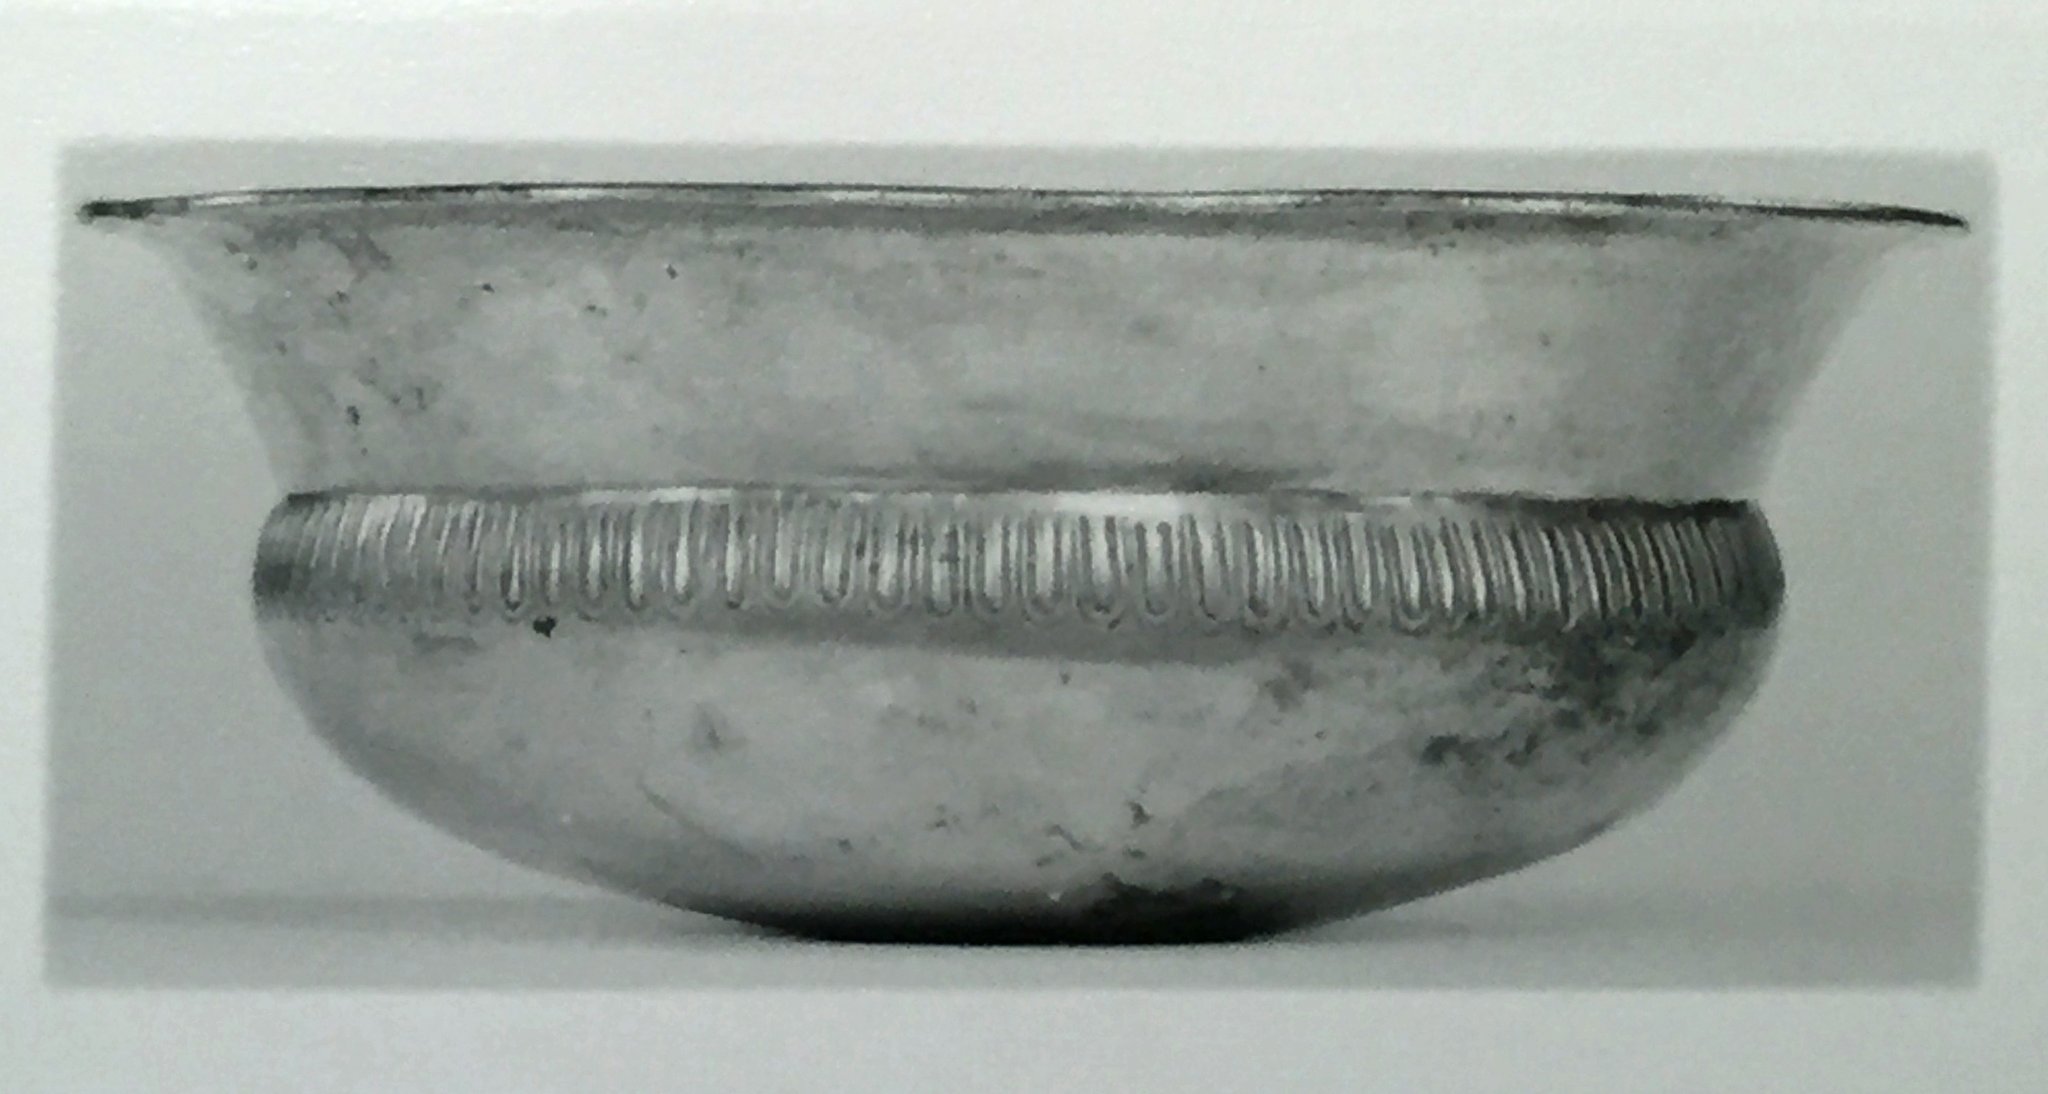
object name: phiale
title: Silver phiale (libation bowl)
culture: east greek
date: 600-501 BCE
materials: silver